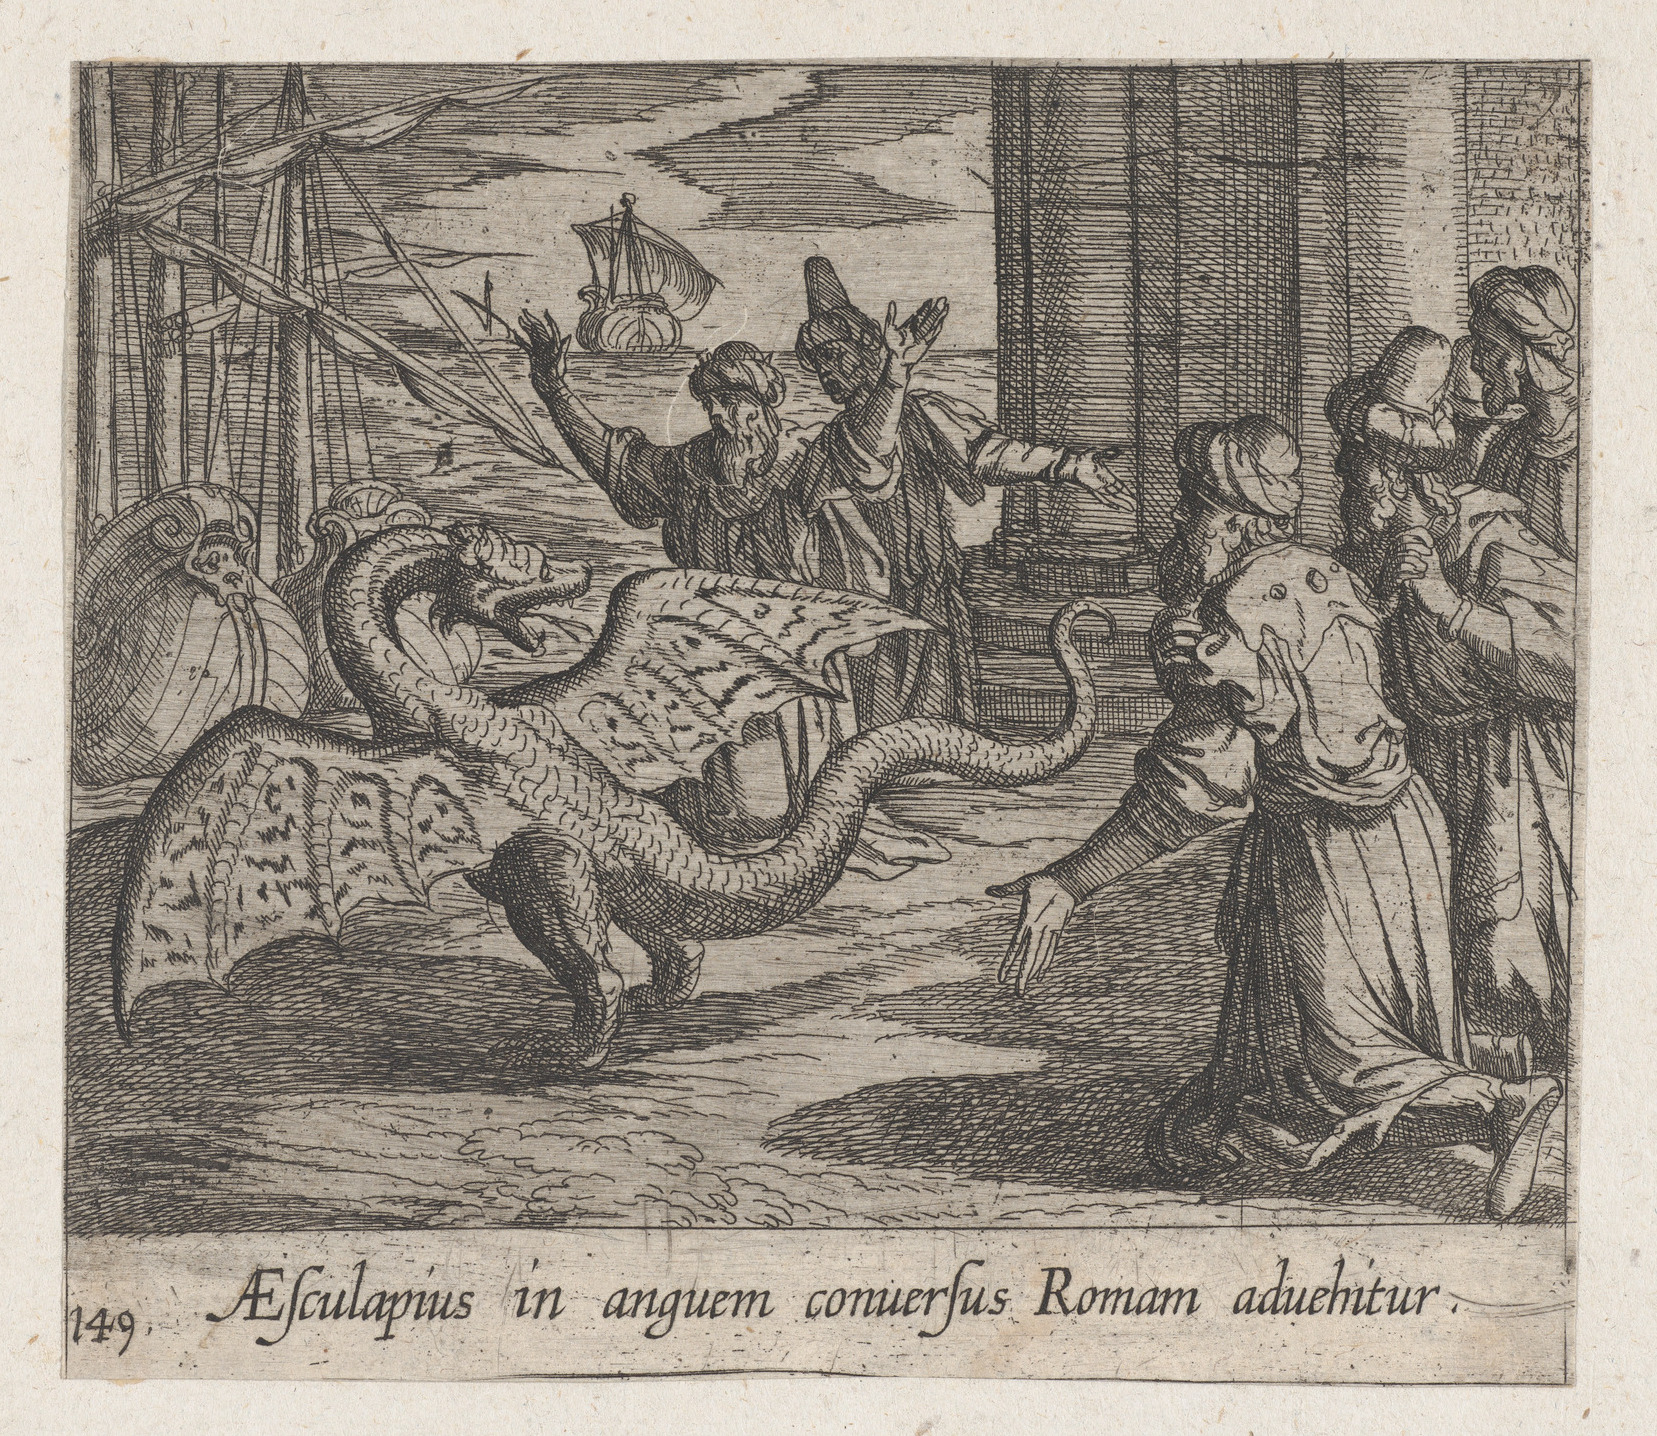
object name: print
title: Plate 149: Aesculapius as a Serpent, Among the Romans (AEsculapius in anguem conversus Roman advehitur), from Ovid's "Metamorphoses"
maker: antonio tempesta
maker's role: artist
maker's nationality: italian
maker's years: 1555-1630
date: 1606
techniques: etching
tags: men,serpents,boats